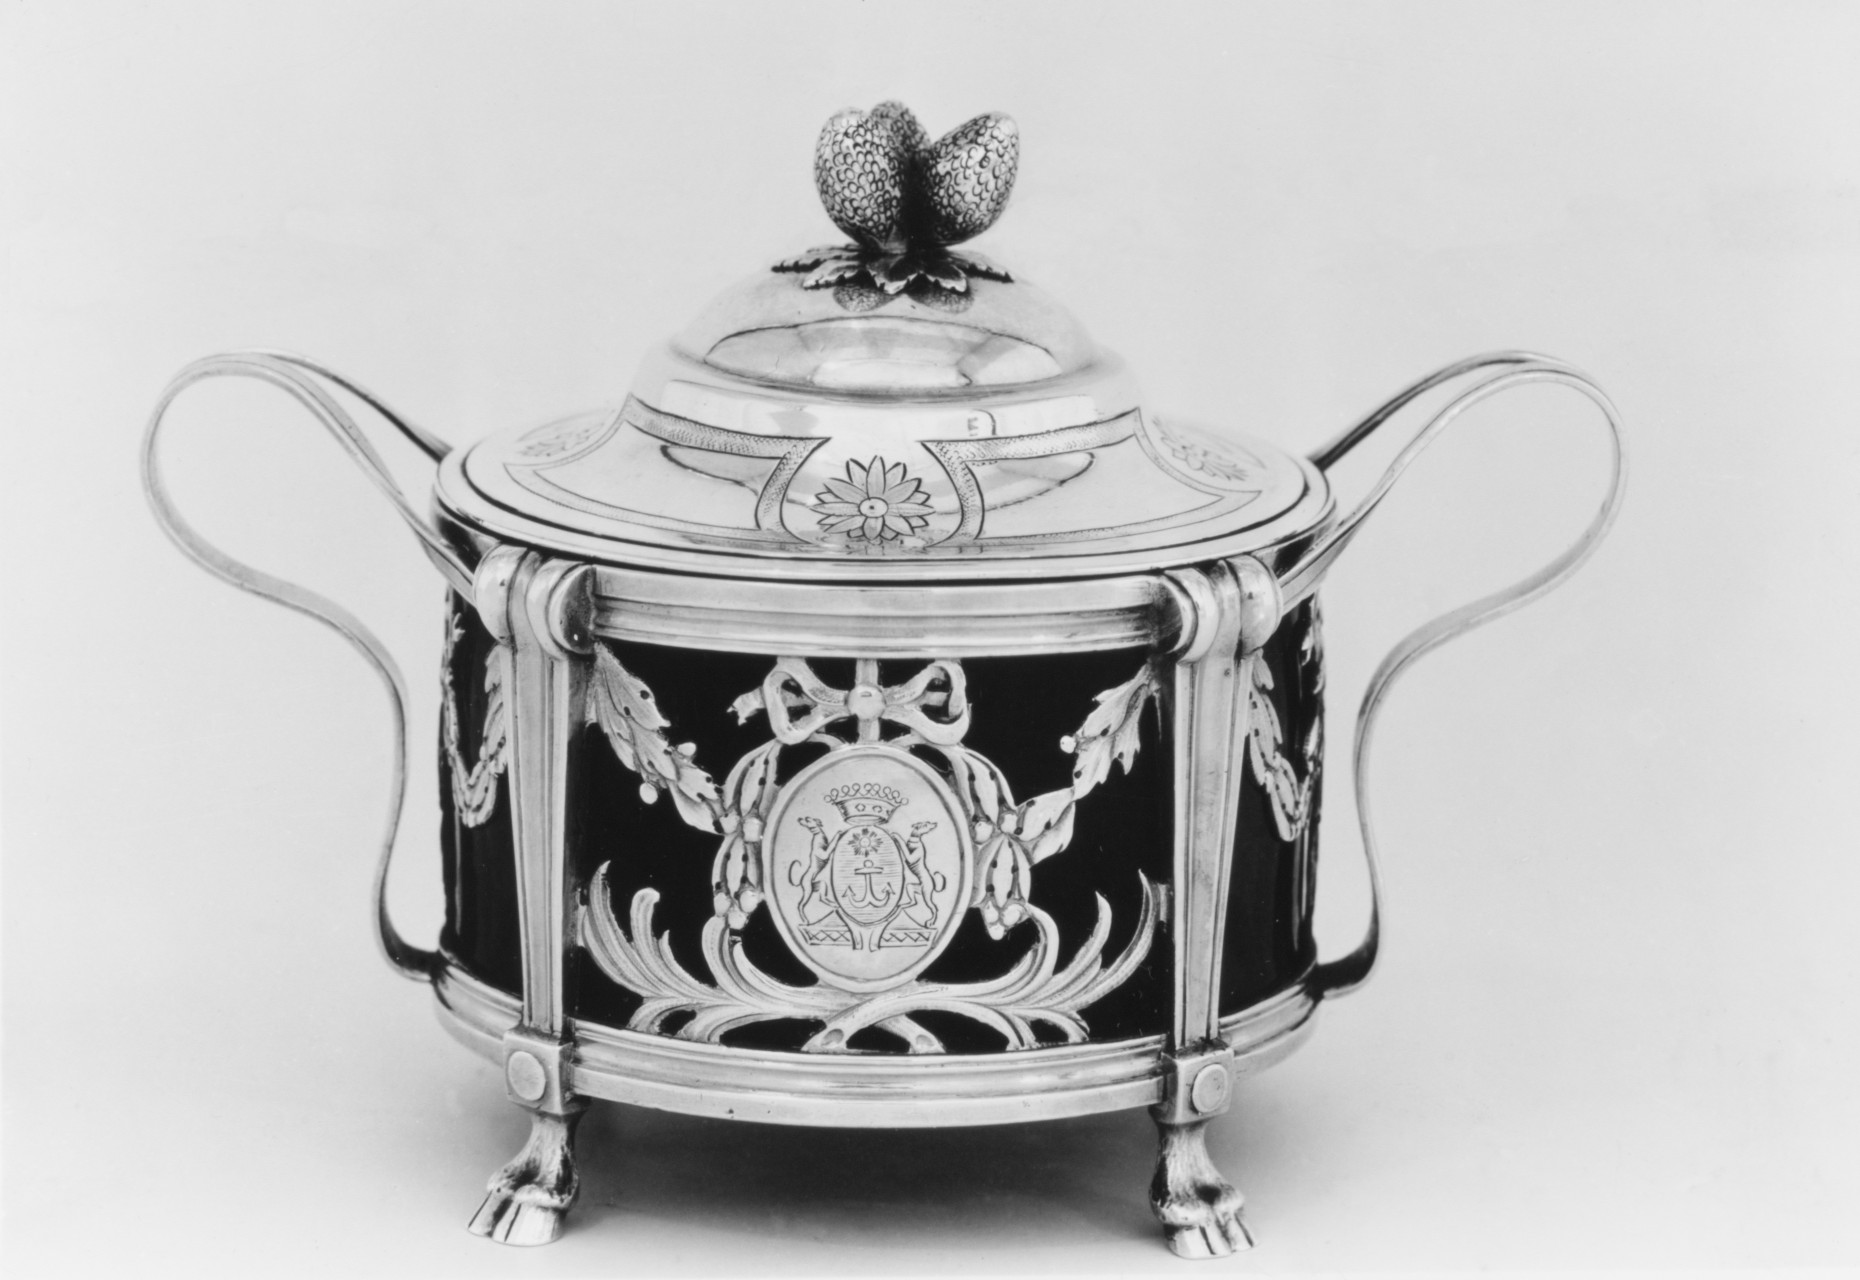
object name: sugar bowl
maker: pierre benardié (or berardier)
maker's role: maker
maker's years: 1745-1822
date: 1775-1781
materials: glass, silver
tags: coat of arms